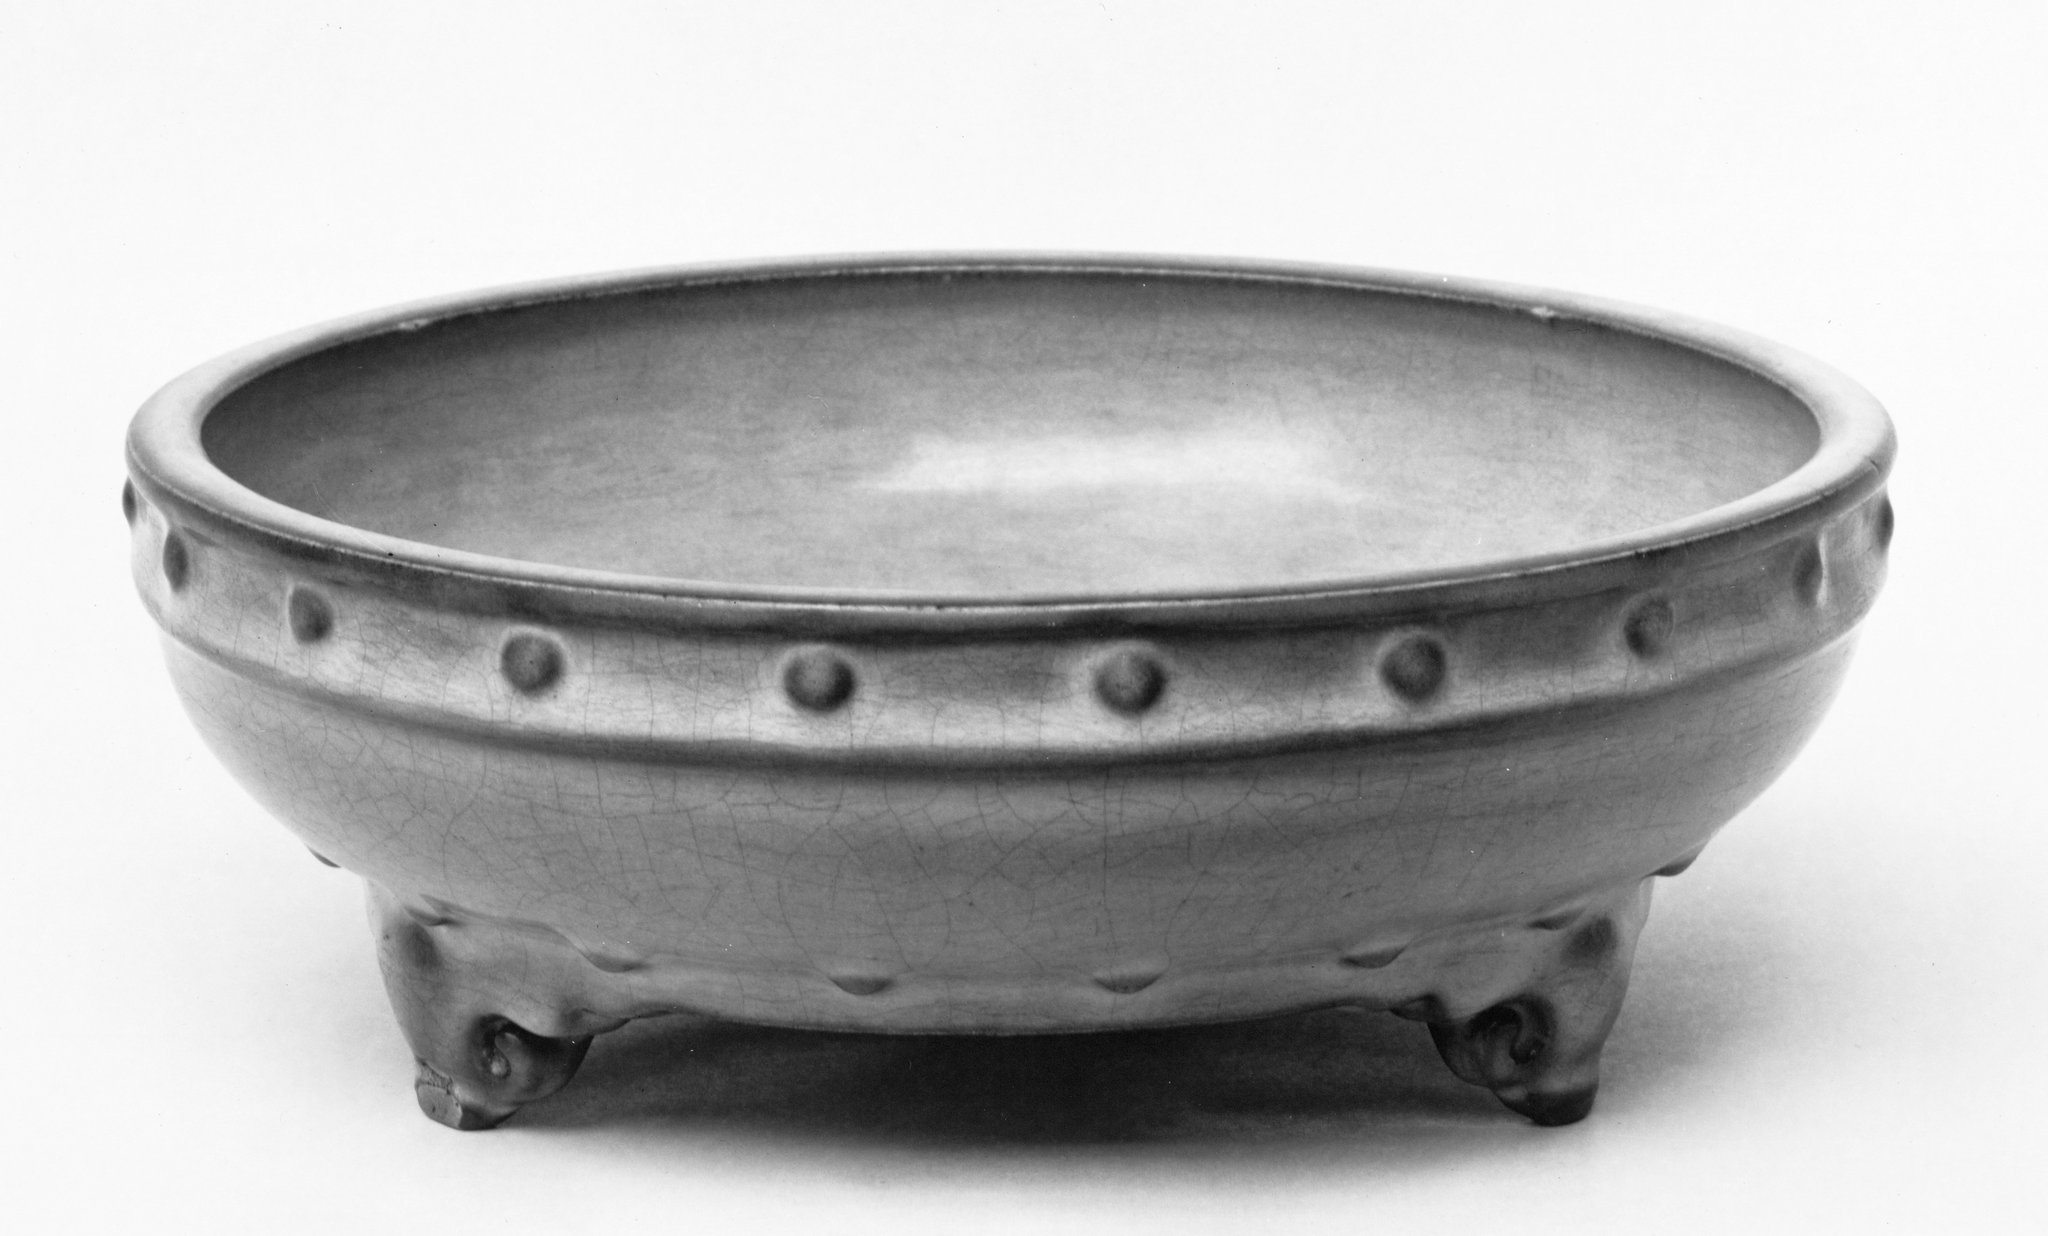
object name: bowl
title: Bulb Bowl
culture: chinese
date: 1201-1400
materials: glaze, stoneware